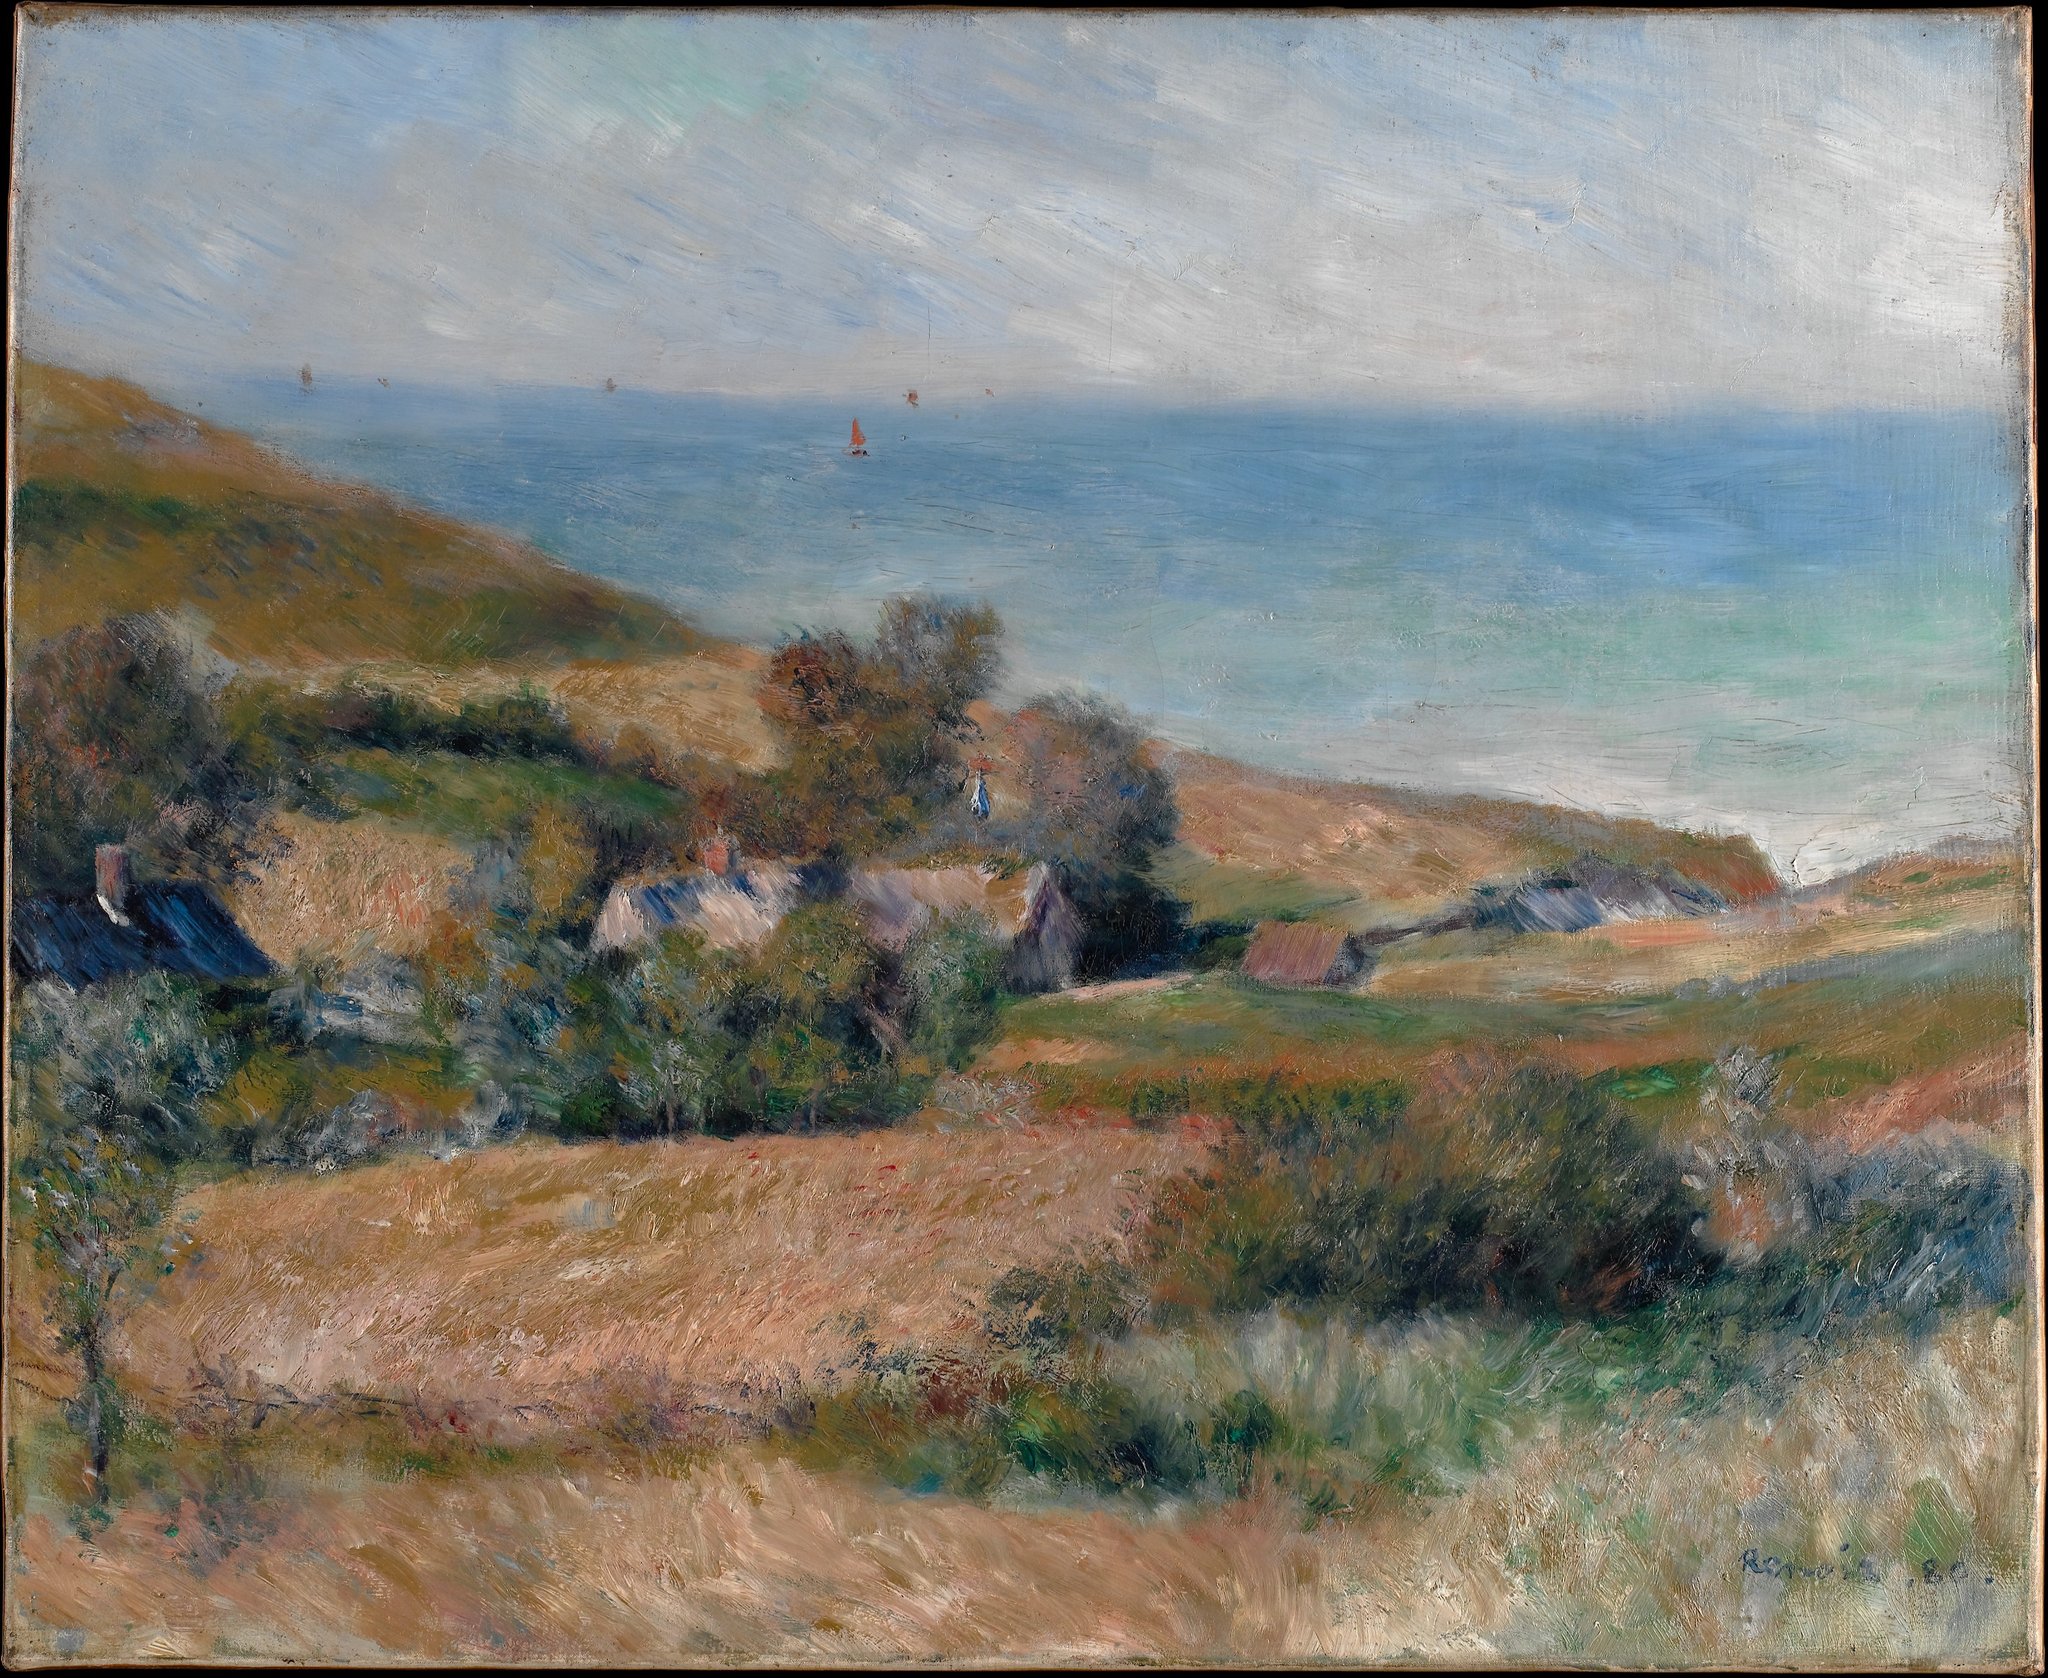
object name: painting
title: View of the Seacoast near Wargemont in Normandy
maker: pierre auguste renoir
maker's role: artist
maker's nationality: french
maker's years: 1841-1919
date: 1880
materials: canvas, oil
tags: seas,landscapes